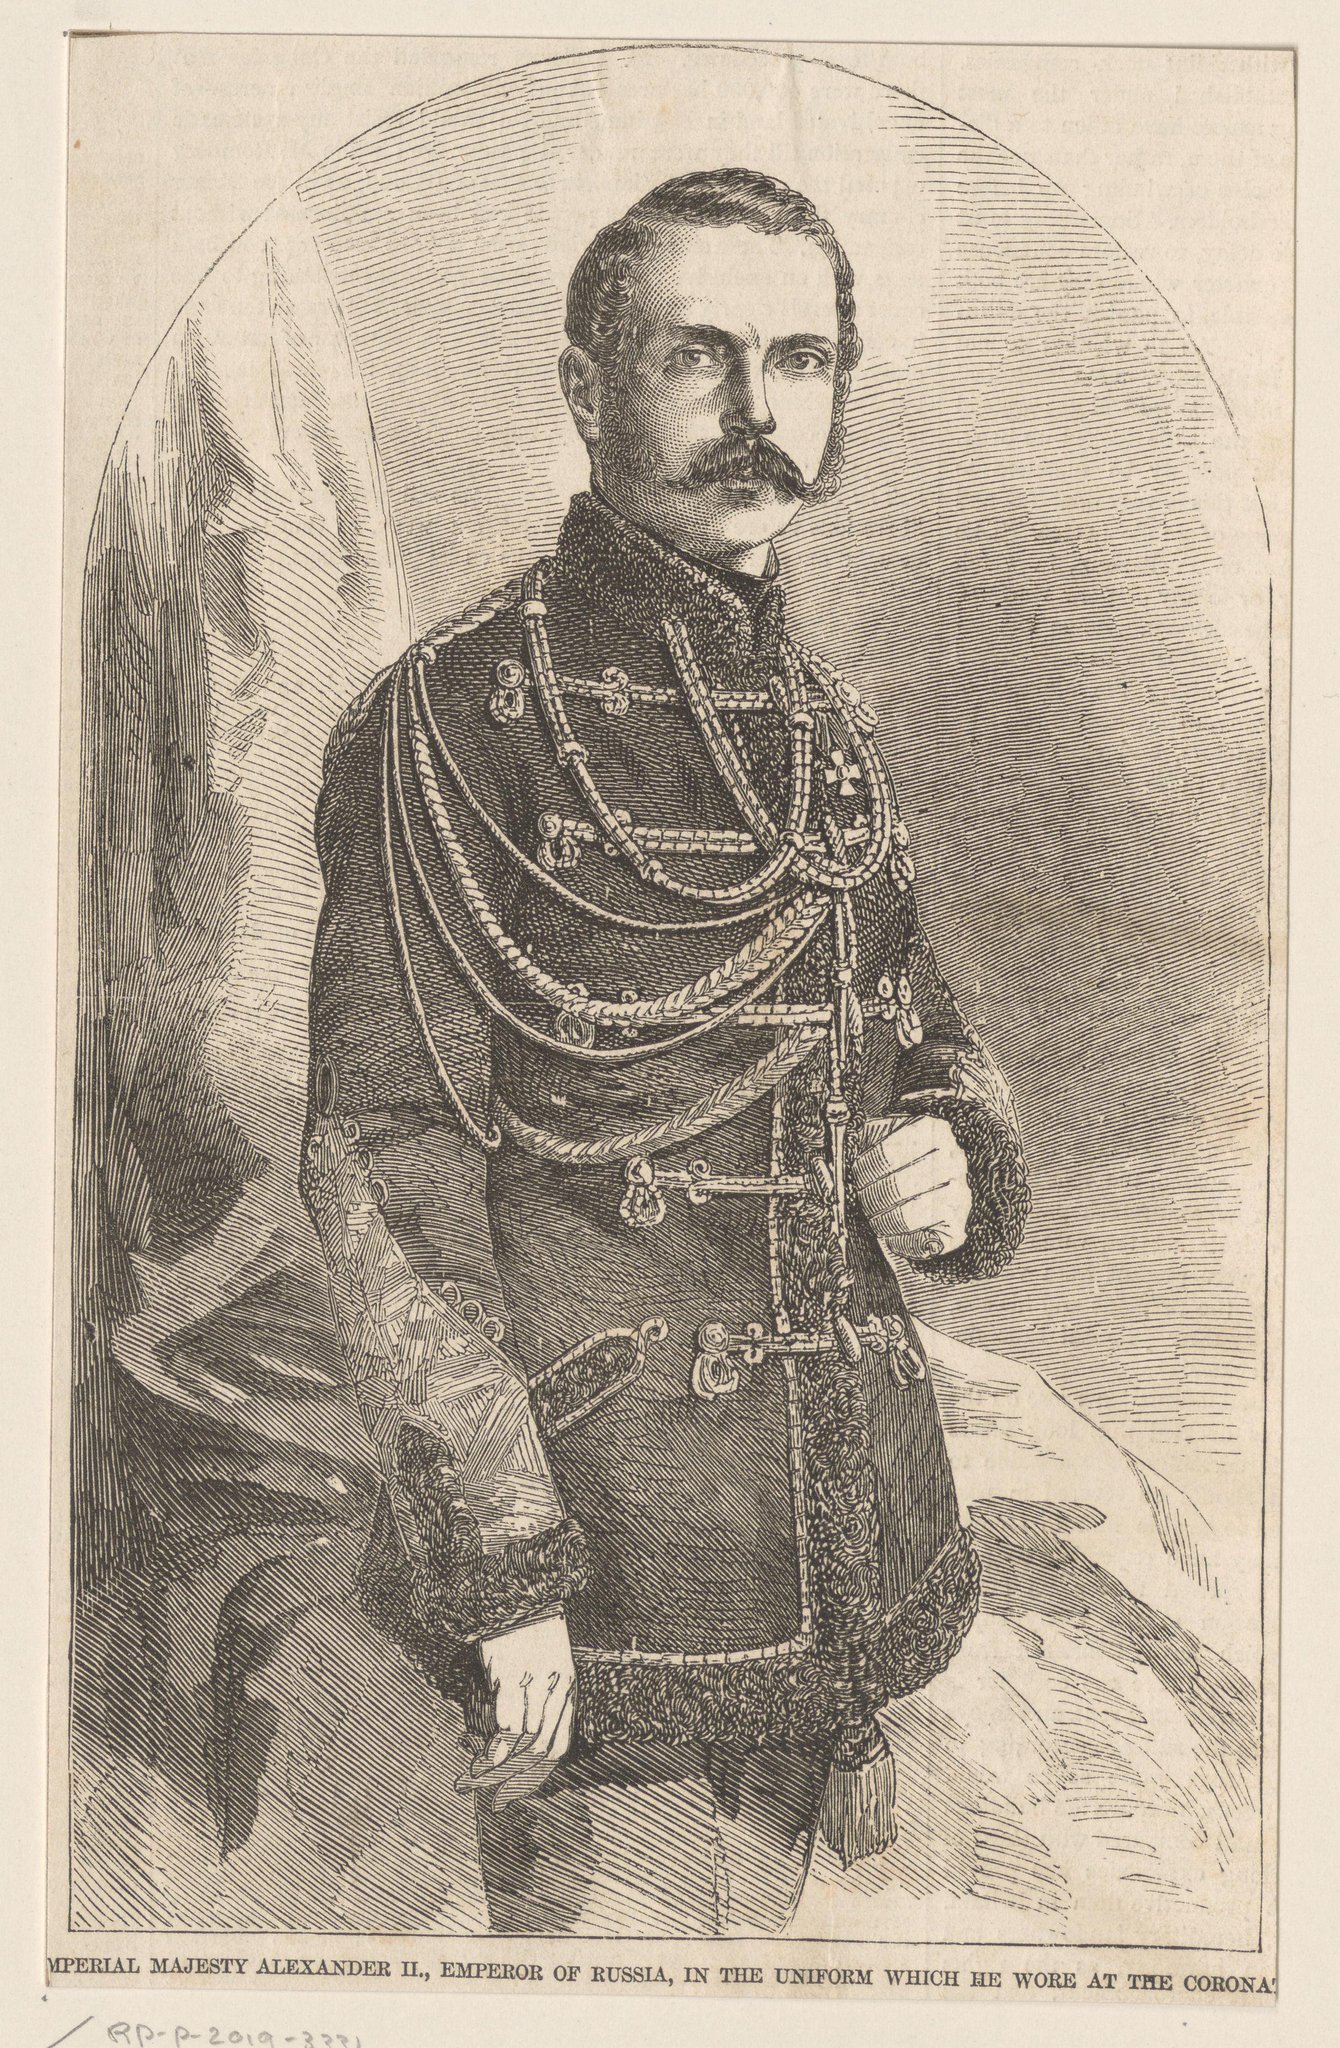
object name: print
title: Portret van Alexander II, tsaar van Rusland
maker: Anonymous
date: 1856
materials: paper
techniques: letterpress printing, engraving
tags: historical persons, emperor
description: Prent uit: The Illustrated London News, nr. 822, 27 september 1856, p. 318.